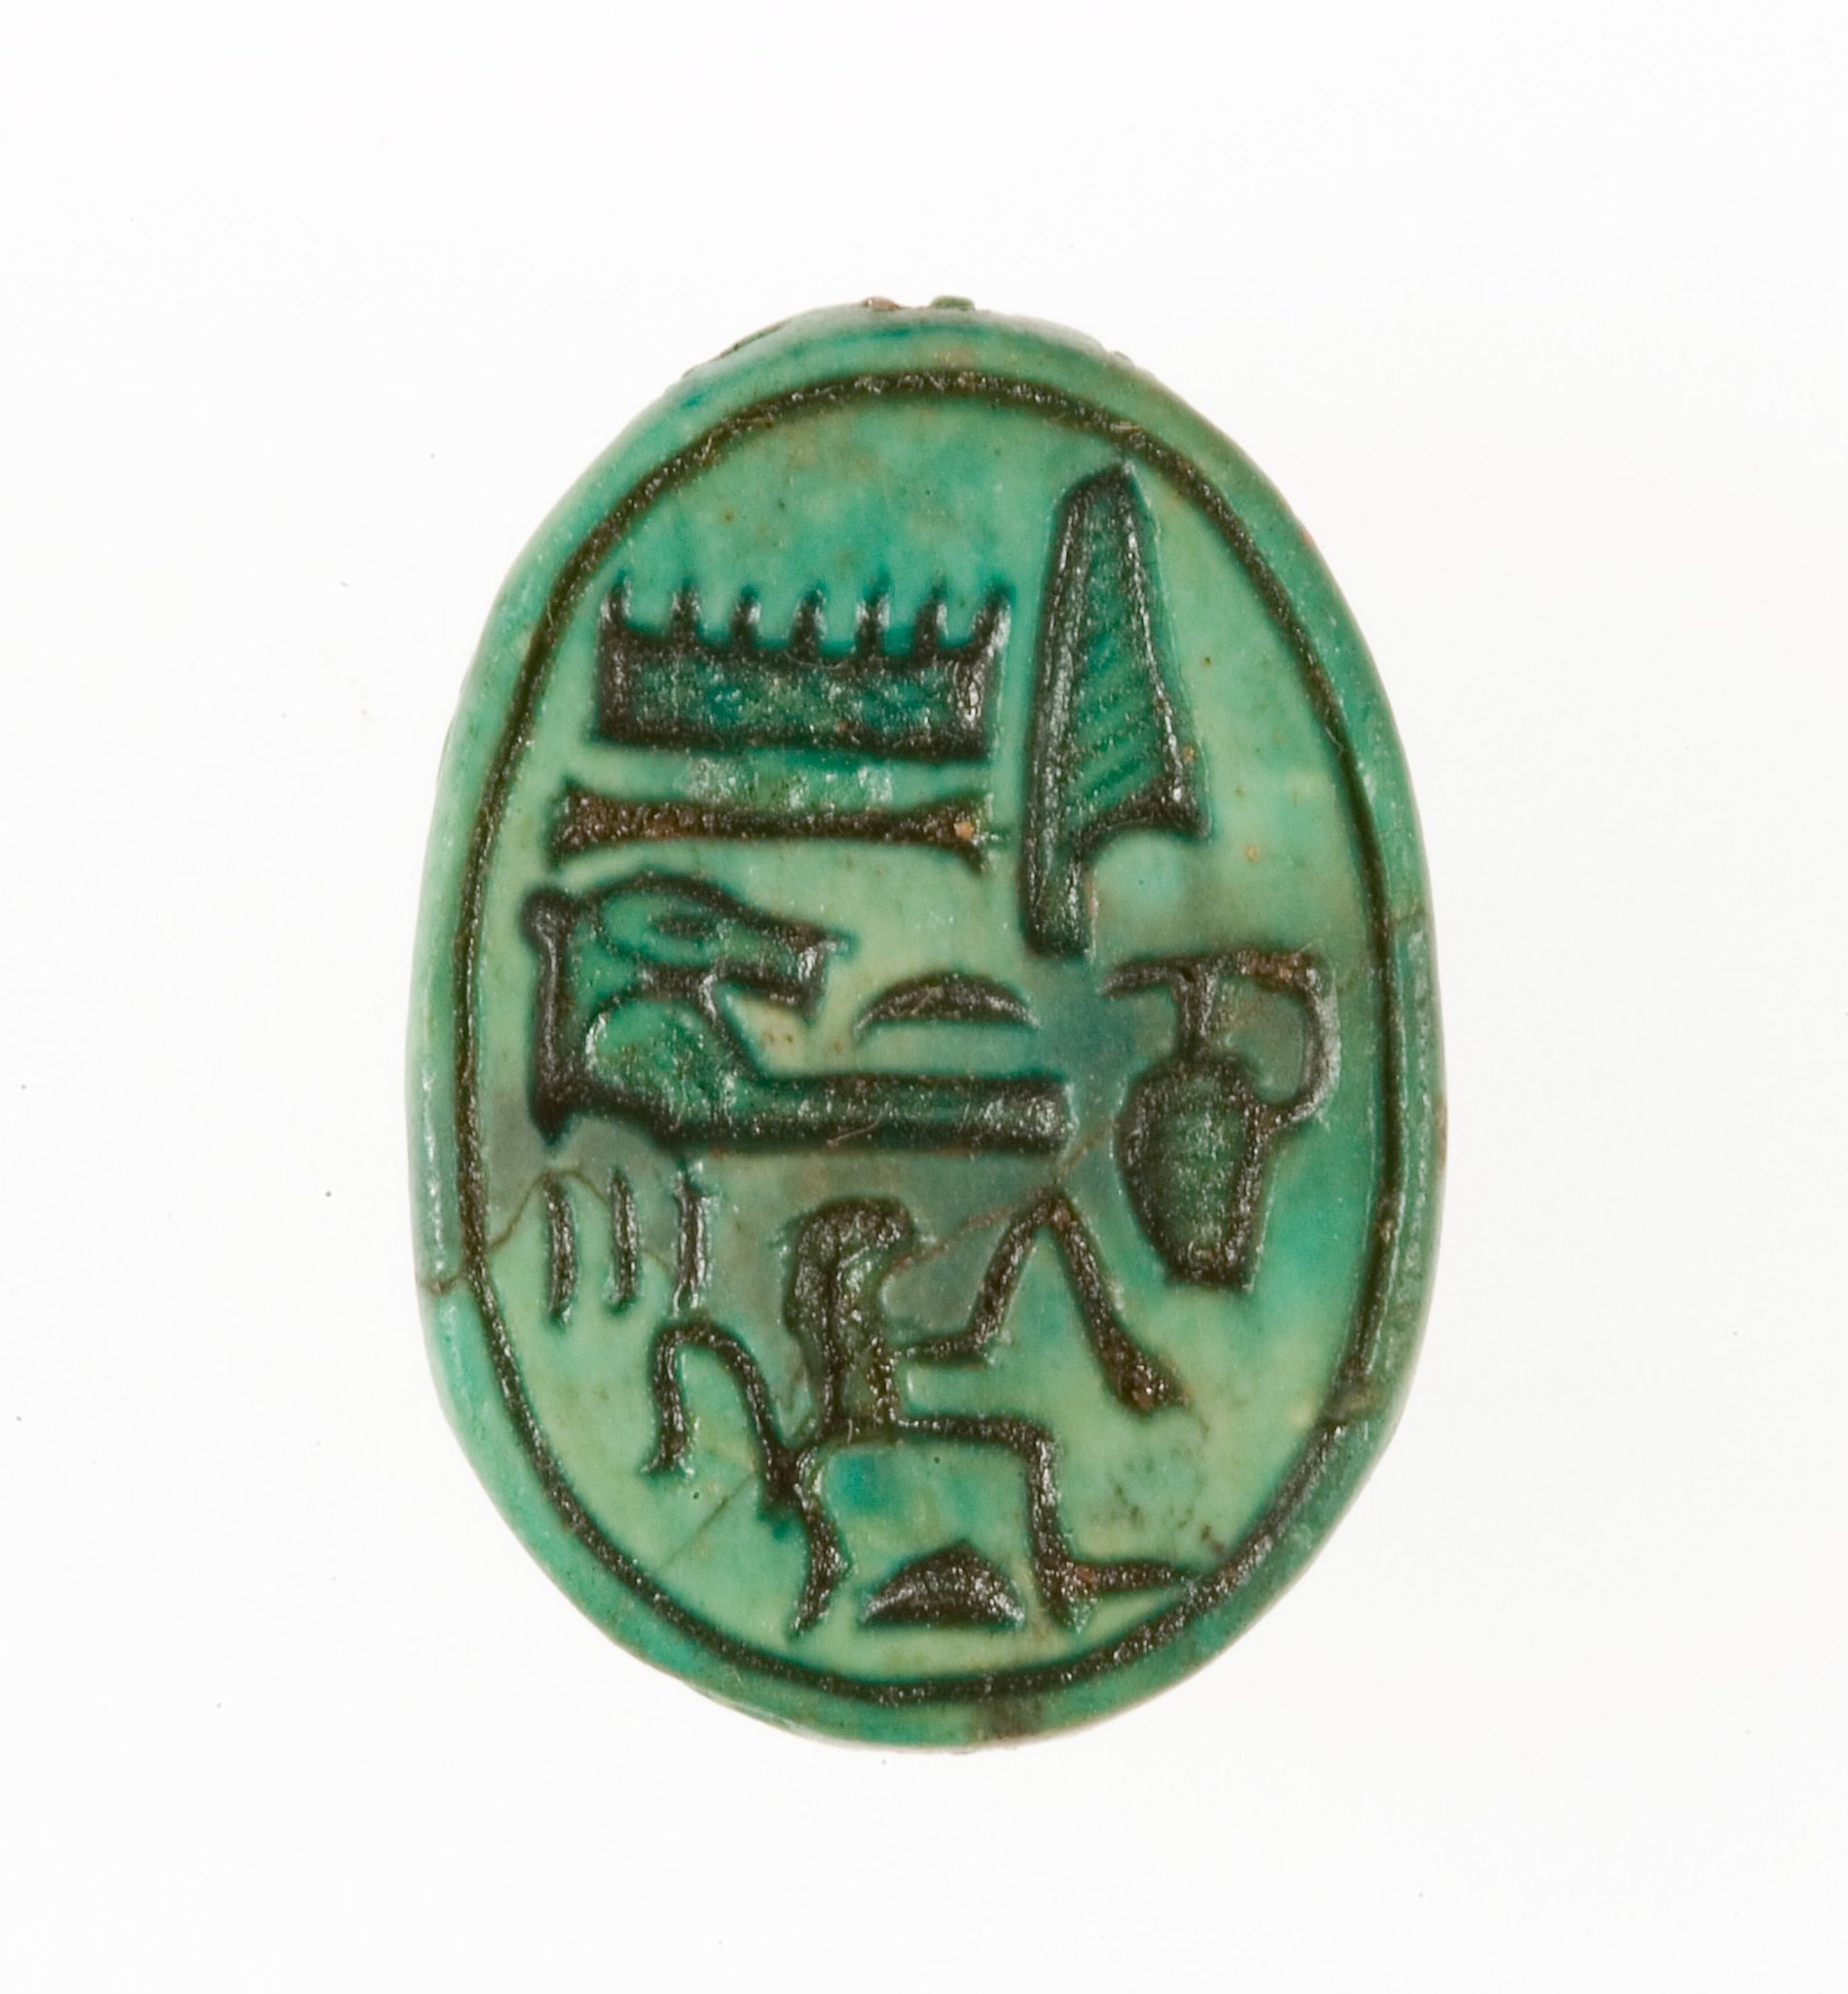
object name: scarab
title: Scarabs from Hatshepsut Foundation Deposits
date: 1479-1458 BCE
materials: stone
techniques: glazing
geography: egypt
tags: hieroglyphs,scarabs